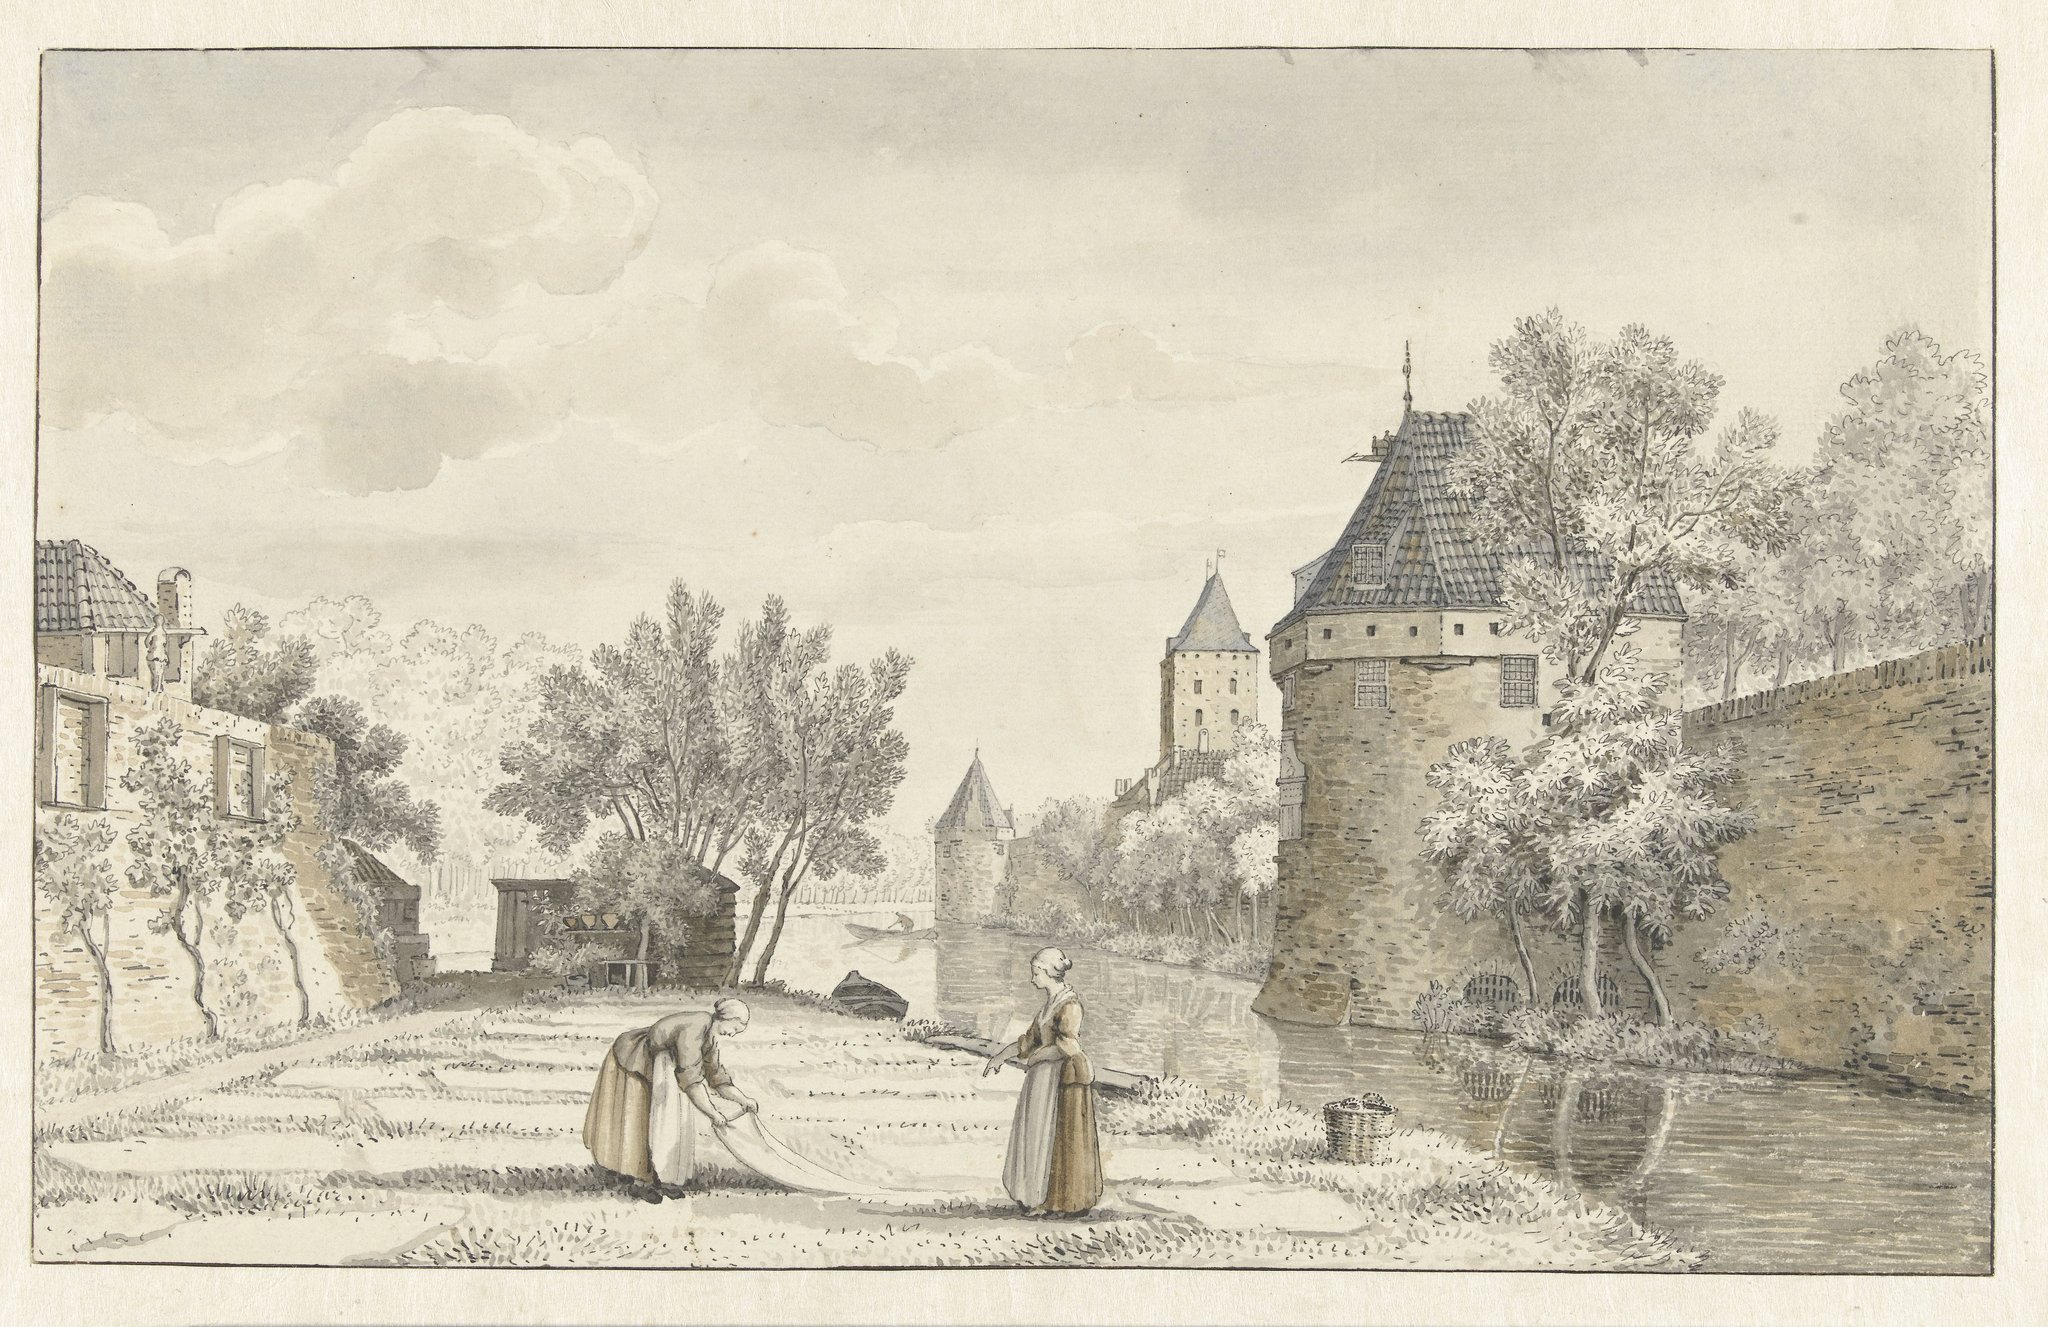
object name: drawing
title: Gezicht op de Plompetoren te Utrecht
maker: johannes de bosch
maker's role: draughtsman, print maker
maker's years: 1713-1785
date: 1748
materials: ink, paper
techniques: brush, pen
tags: towers ~ fortified city, bleaching (laundering), city-gate, utrecht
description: Gezicht op de Plompetoren te Utrecht, op de voorgrond twee vrouwen die linnen bleken.